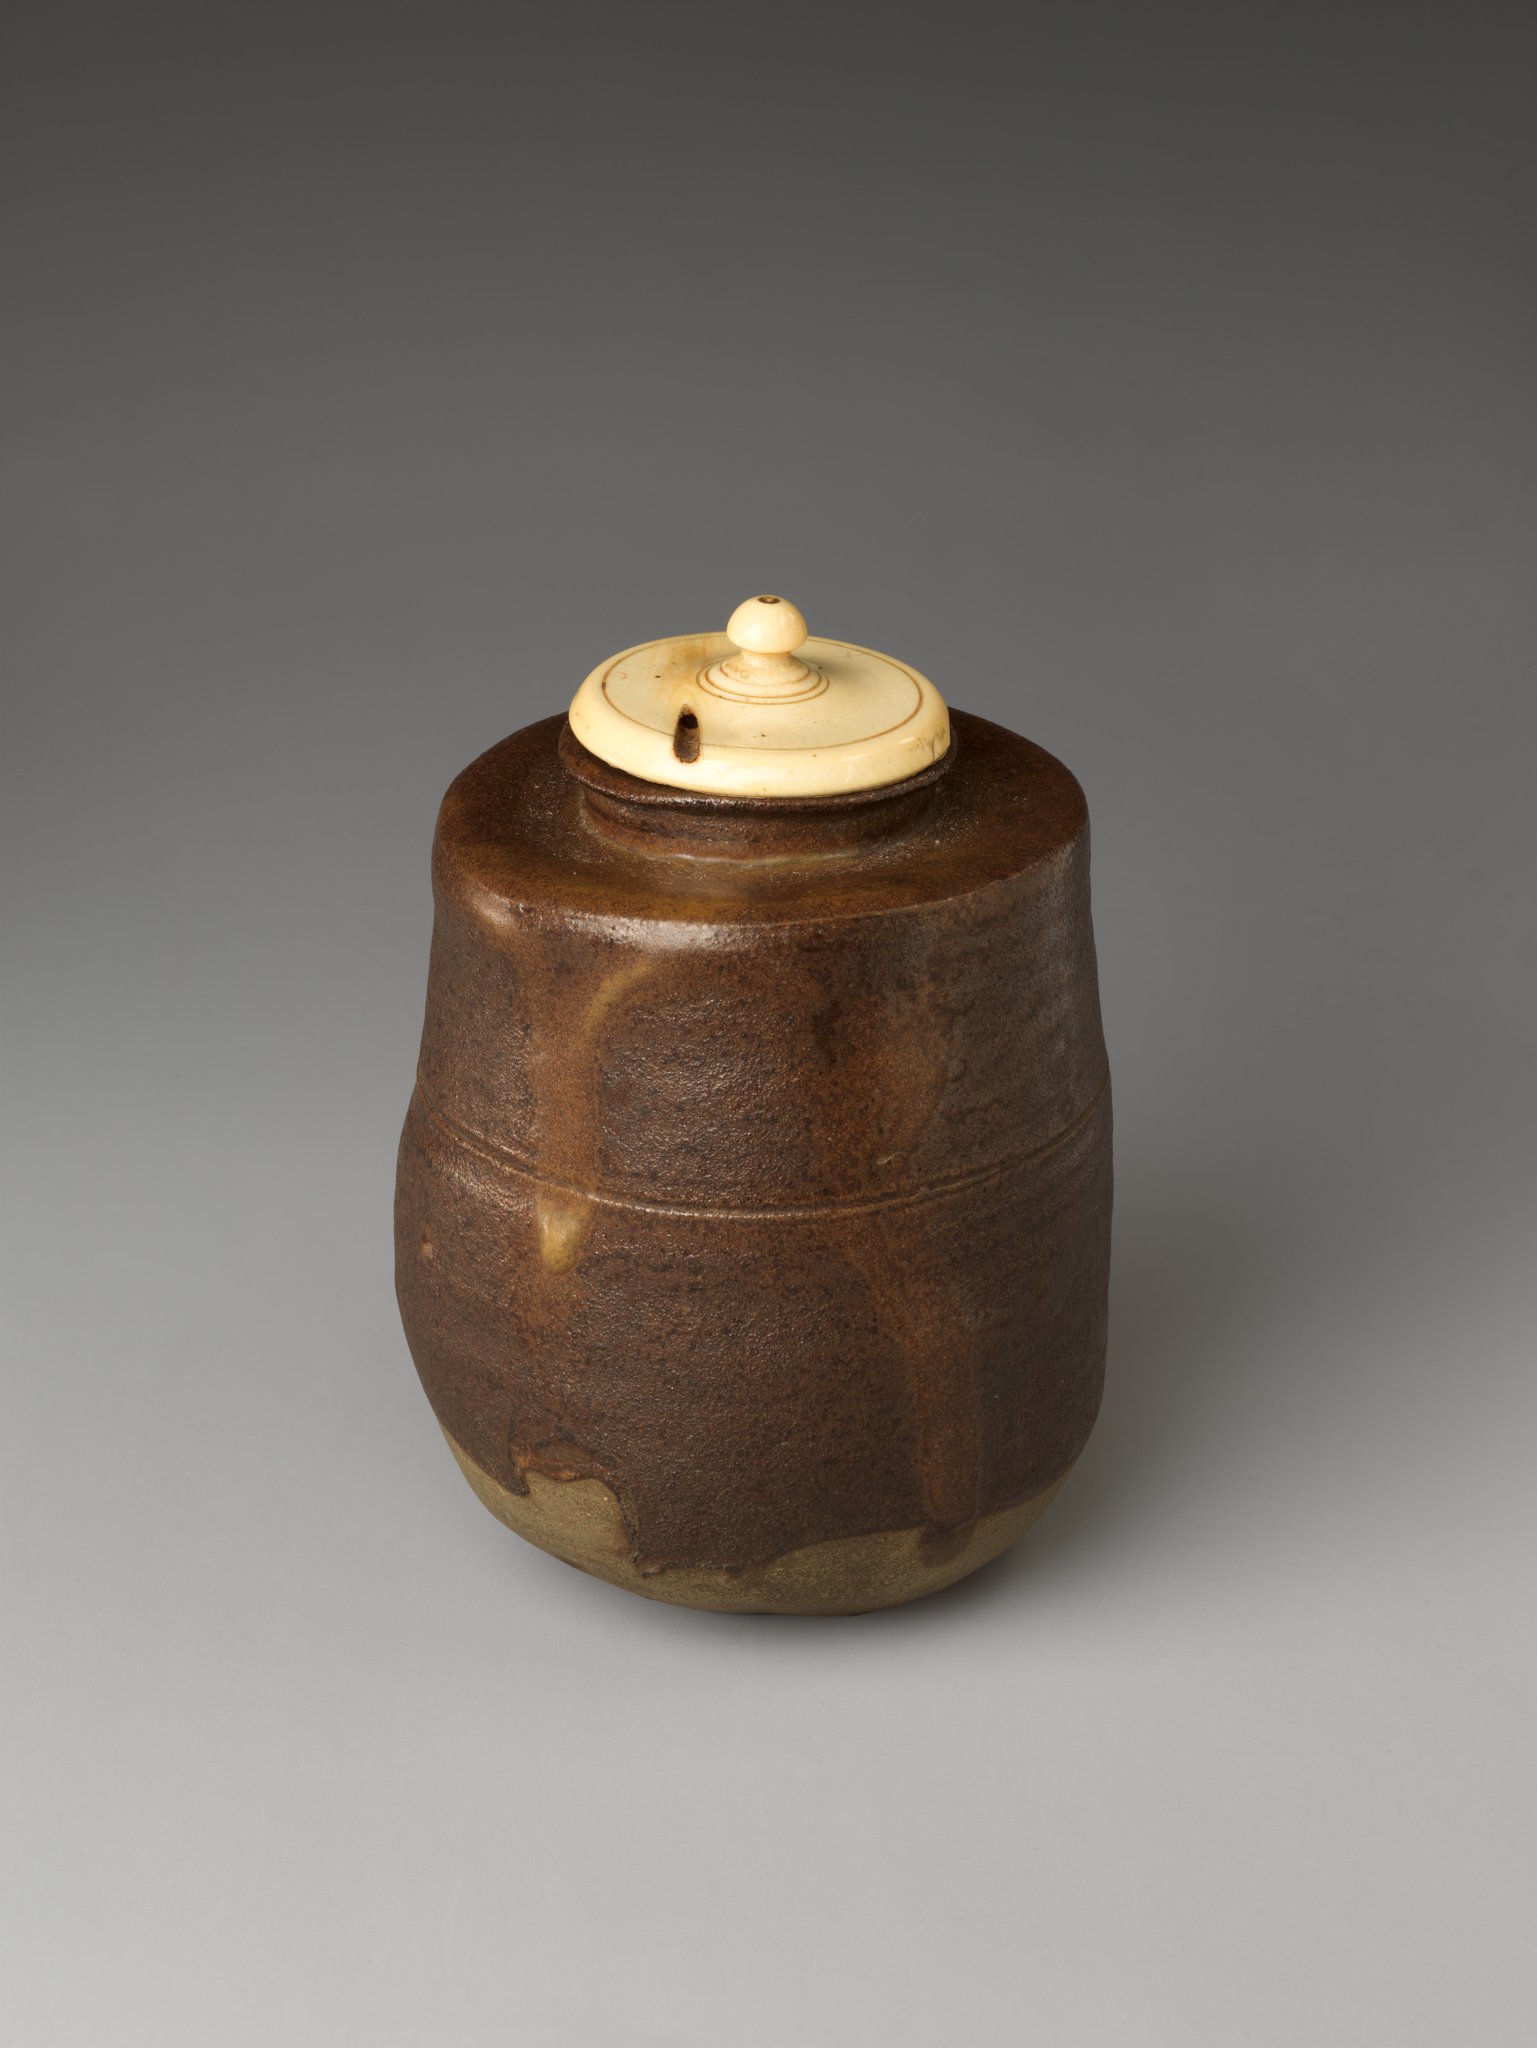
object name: tea caddy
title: Eggplant-shaped Tea Caddy (Chaire), named Shira Tsuyu (White Dew)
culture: japanese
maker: shinbei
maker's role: artist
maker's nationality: japanese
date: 1601-1700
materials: glaze, iron, ivory, stoneware